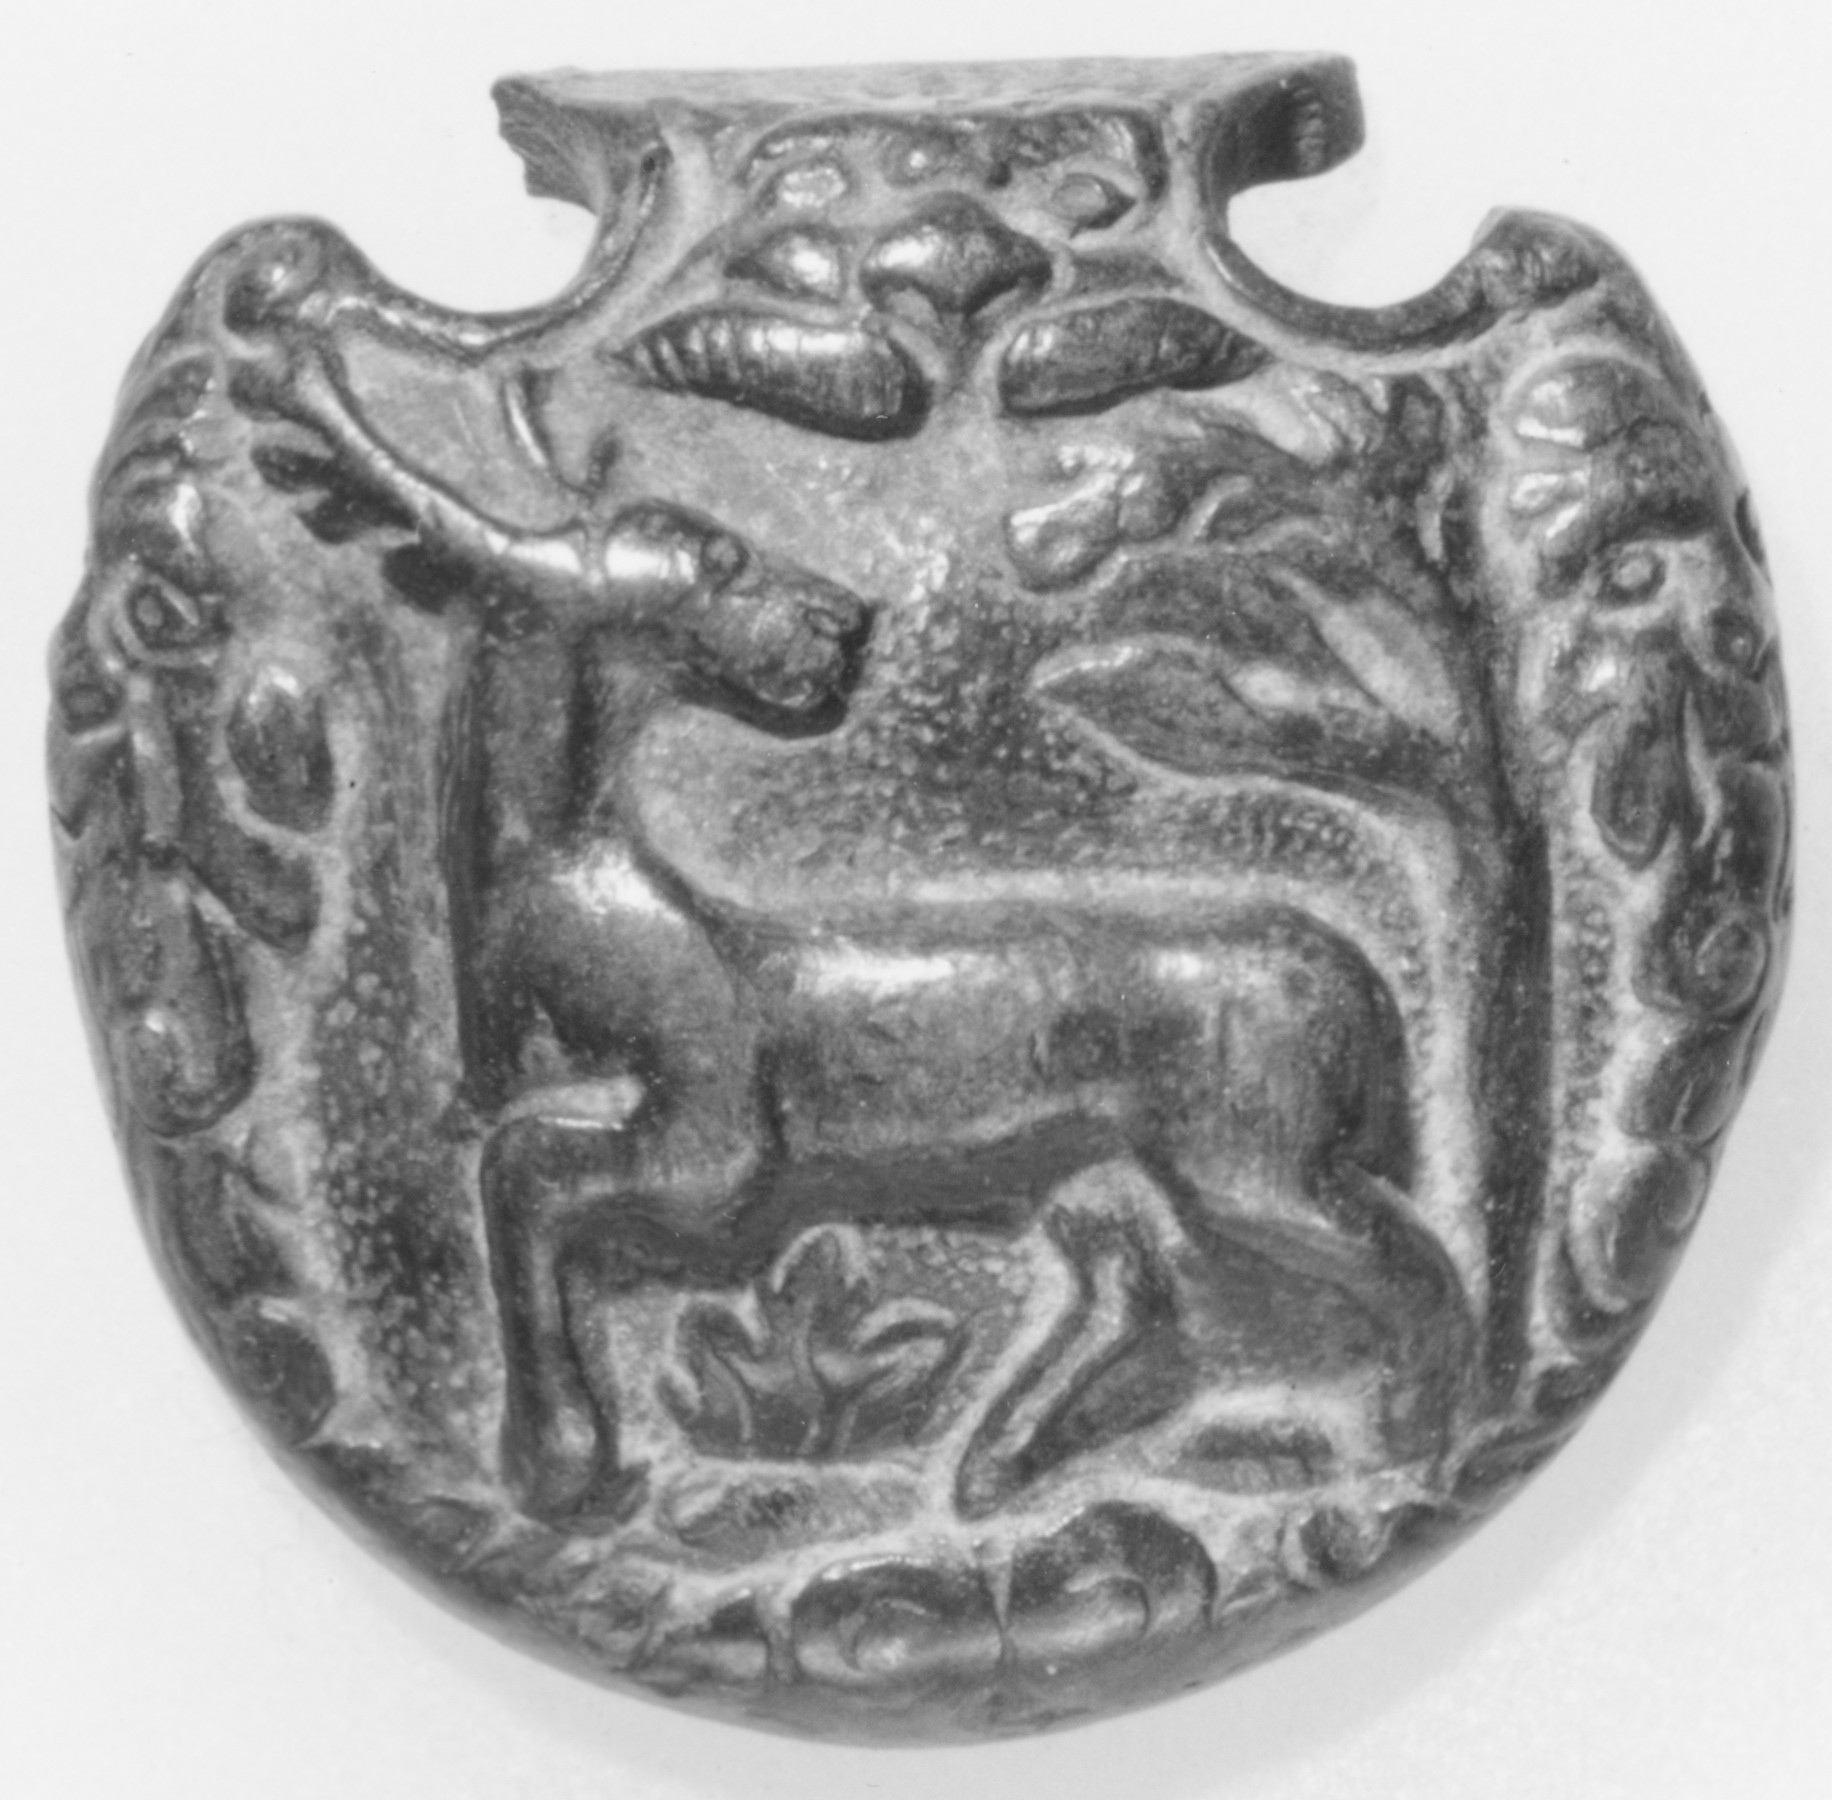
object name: plaquette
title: Sword Guard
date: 1501-1700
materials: bronze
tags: military equipment,deer